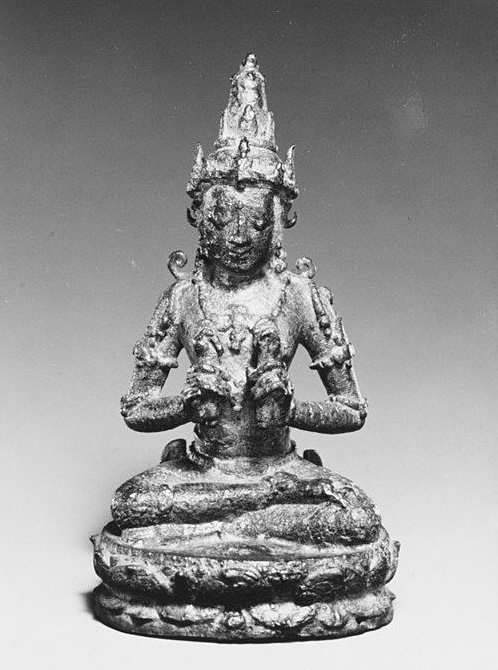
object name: figurine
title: Seated Male Deity Holding Two Ritual Objects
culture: indonesian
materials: bronze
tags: deities